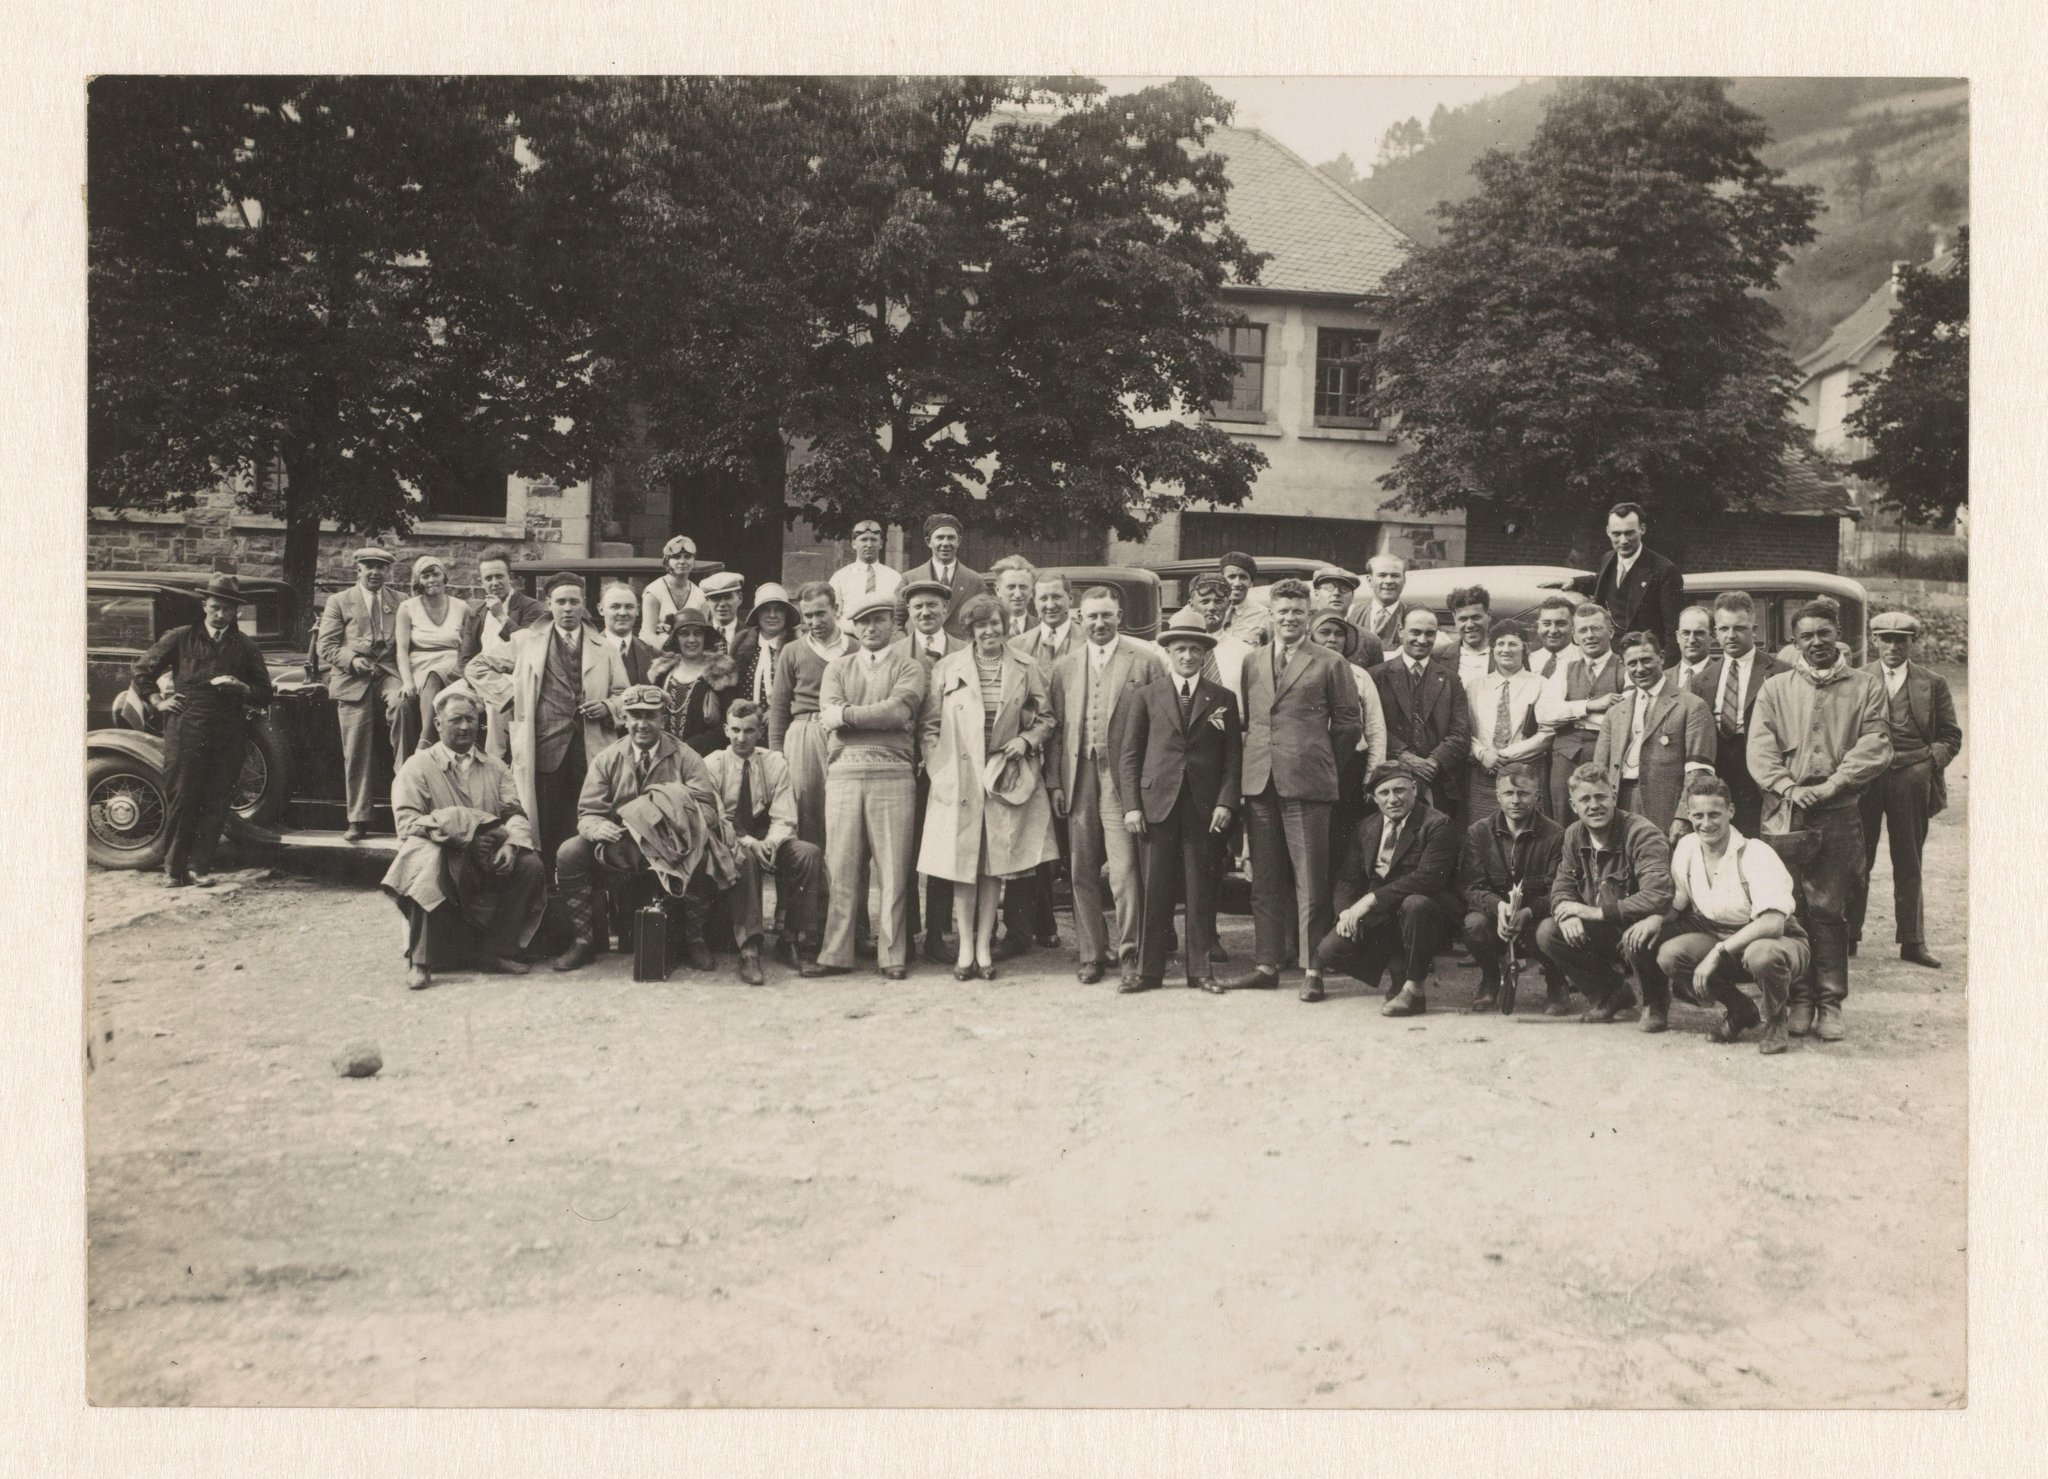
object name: photograph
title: 1929 Nurnburg Ring. Dumonceau Bekurrit Duitsland/ Nederland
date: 1929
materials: paper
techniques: gelatin silver print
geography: arnhem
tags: automobile, germany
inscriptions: annotation: ‘1929 Nurnburg Ring. Dumonceau Bekurrit Duitsland/ Nederland (gewonnen door Nederland met Dirk van der Nork Sr in Nederlands team en geheel links op de foto, met hood) (midden voor op de foto, met lichte hood, persfotograaf Levy)’, stamp: ‘19136 Copyright foto bureau Gazendam Rijnstraat 9 Arnhem’